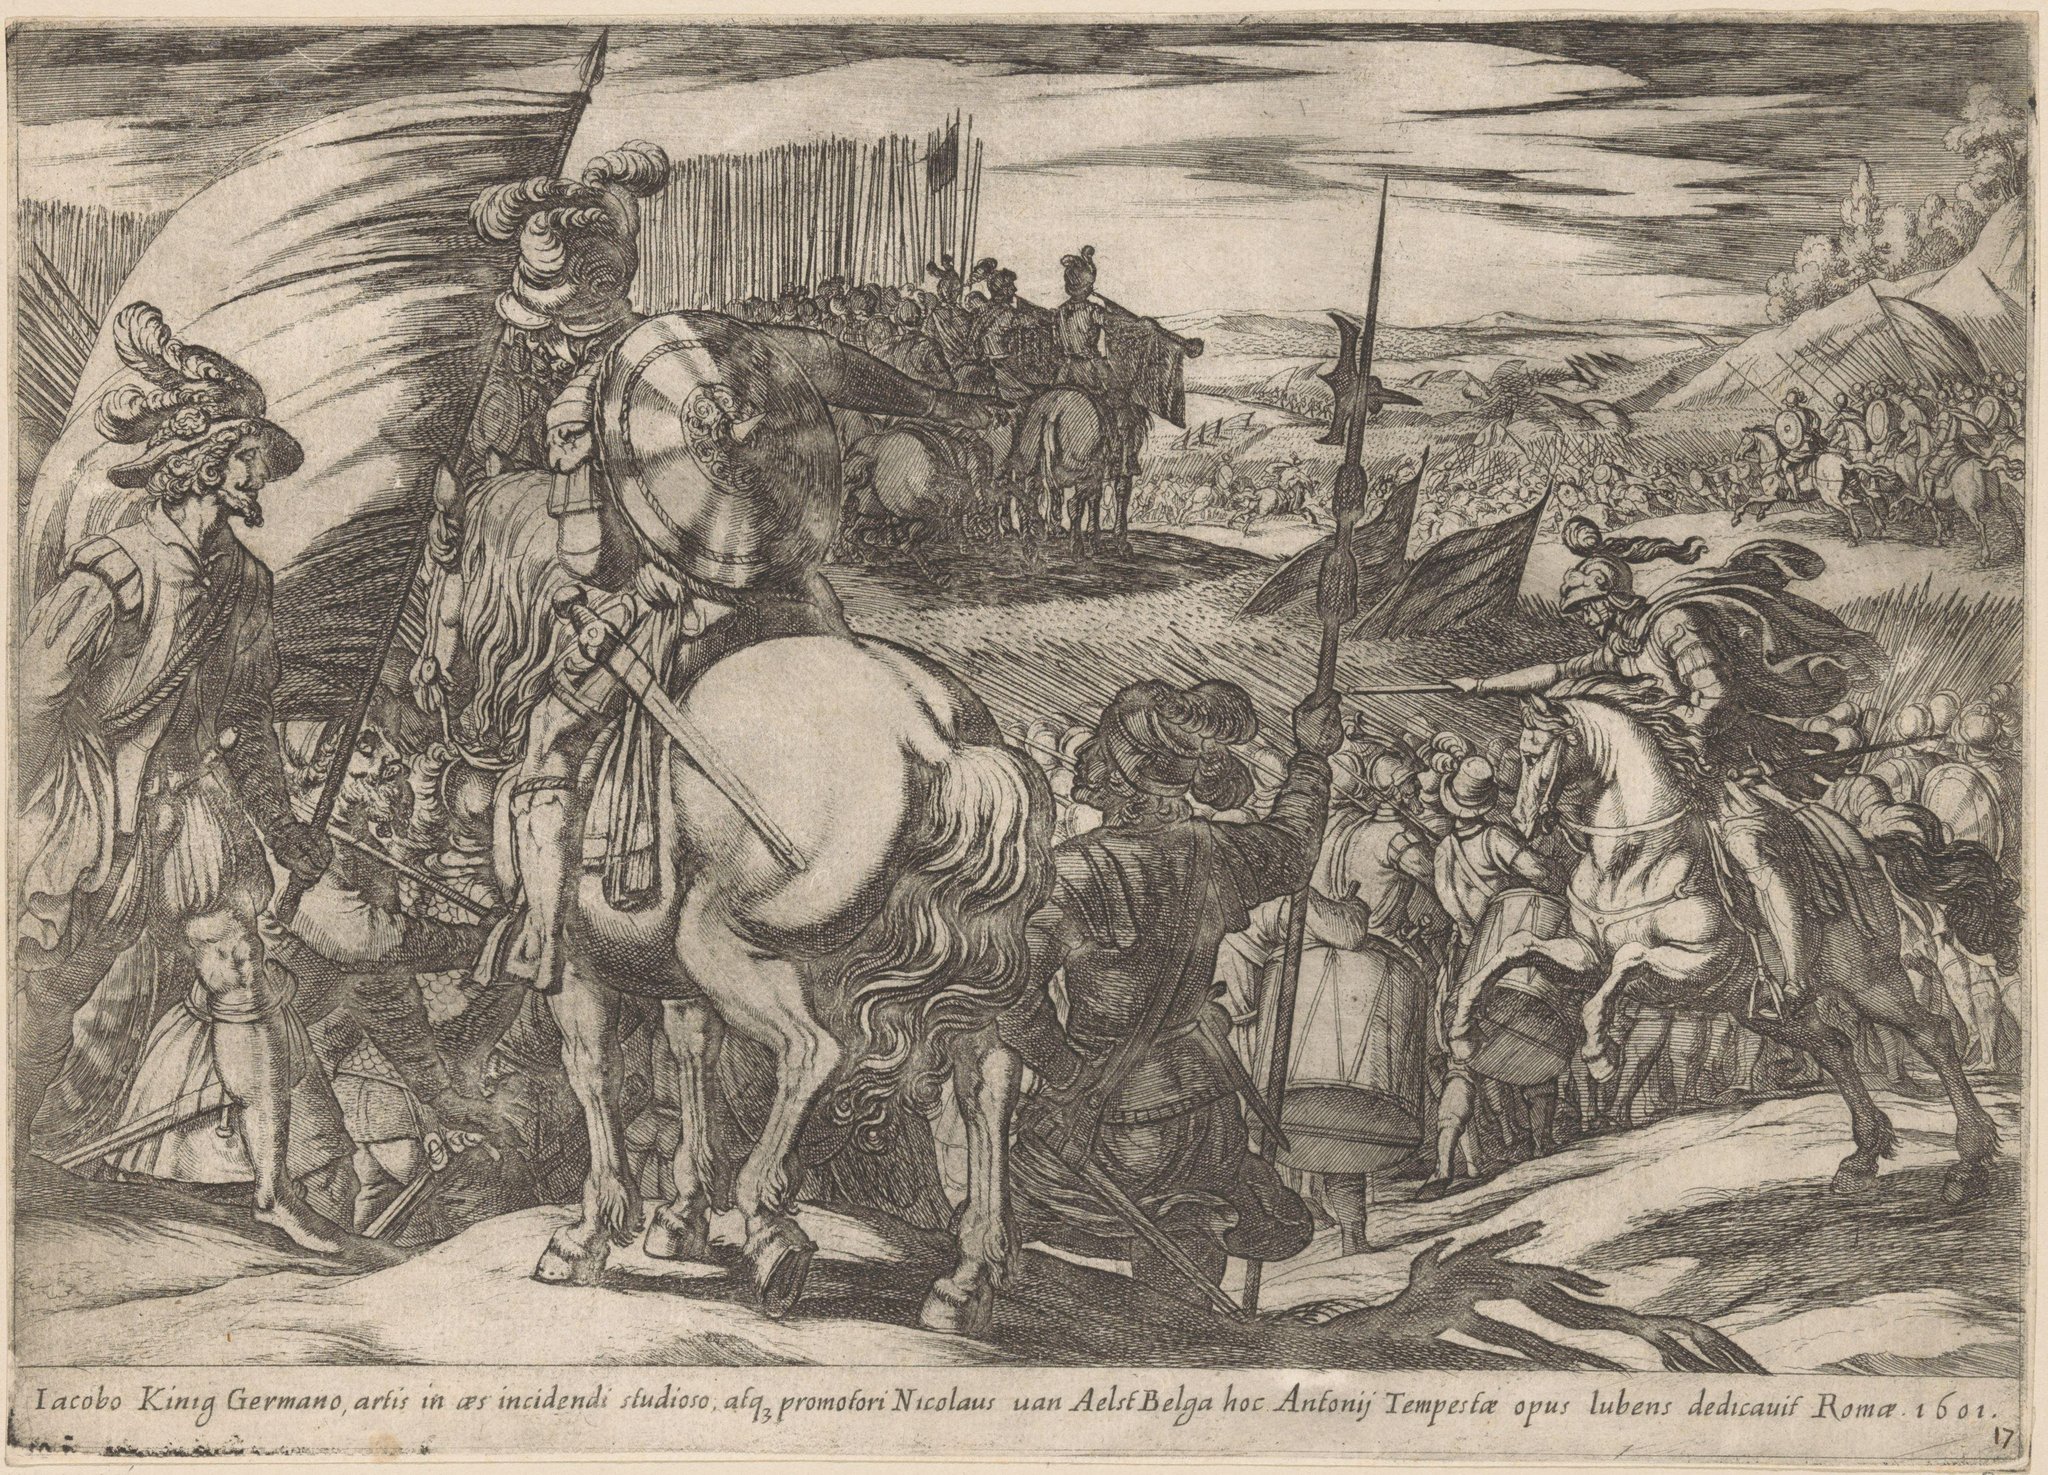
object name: print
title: Een leger bereidt zich voor op de aanval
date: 1601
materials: paper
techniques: etching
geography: rome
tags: battle, warfare; military affairs (+ cavalry, horsemen), the soldier; the soldier's life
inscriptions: collector's mark: Lugt 240, number: ‘17’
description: Een leger bereidt zich voor op de aanval. Links een vaandeldrager en een officier te paard.